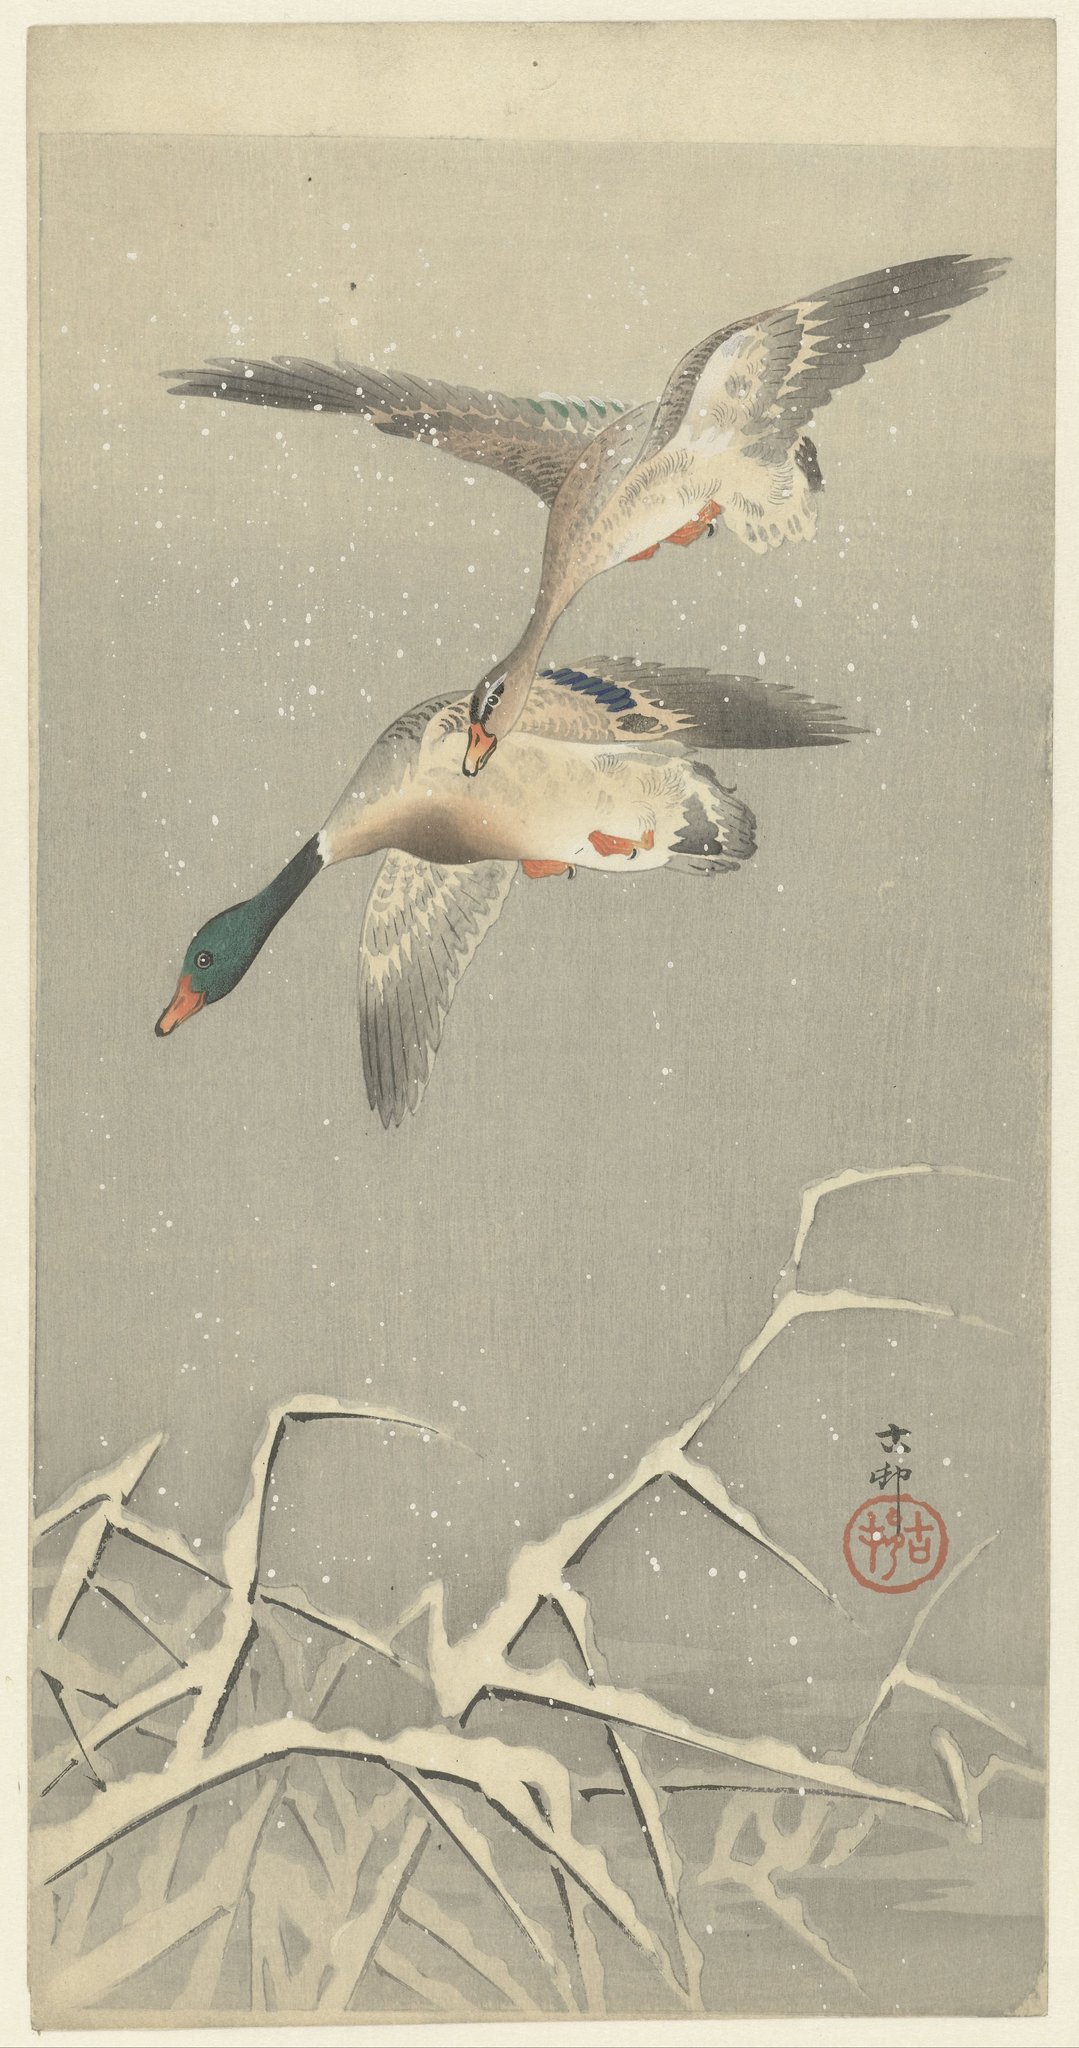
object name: print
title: Twee wilde eenden in vlucht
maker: ohara koson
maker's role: print maker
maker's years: 1877-1945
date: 1900-1936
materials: paper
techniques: woodcut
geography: japan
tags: snow, water-birds: duck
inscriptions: collector's mark: Lugt 2228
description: Twee eenden in vlucht, boven rietkraag, in de sneeuw.